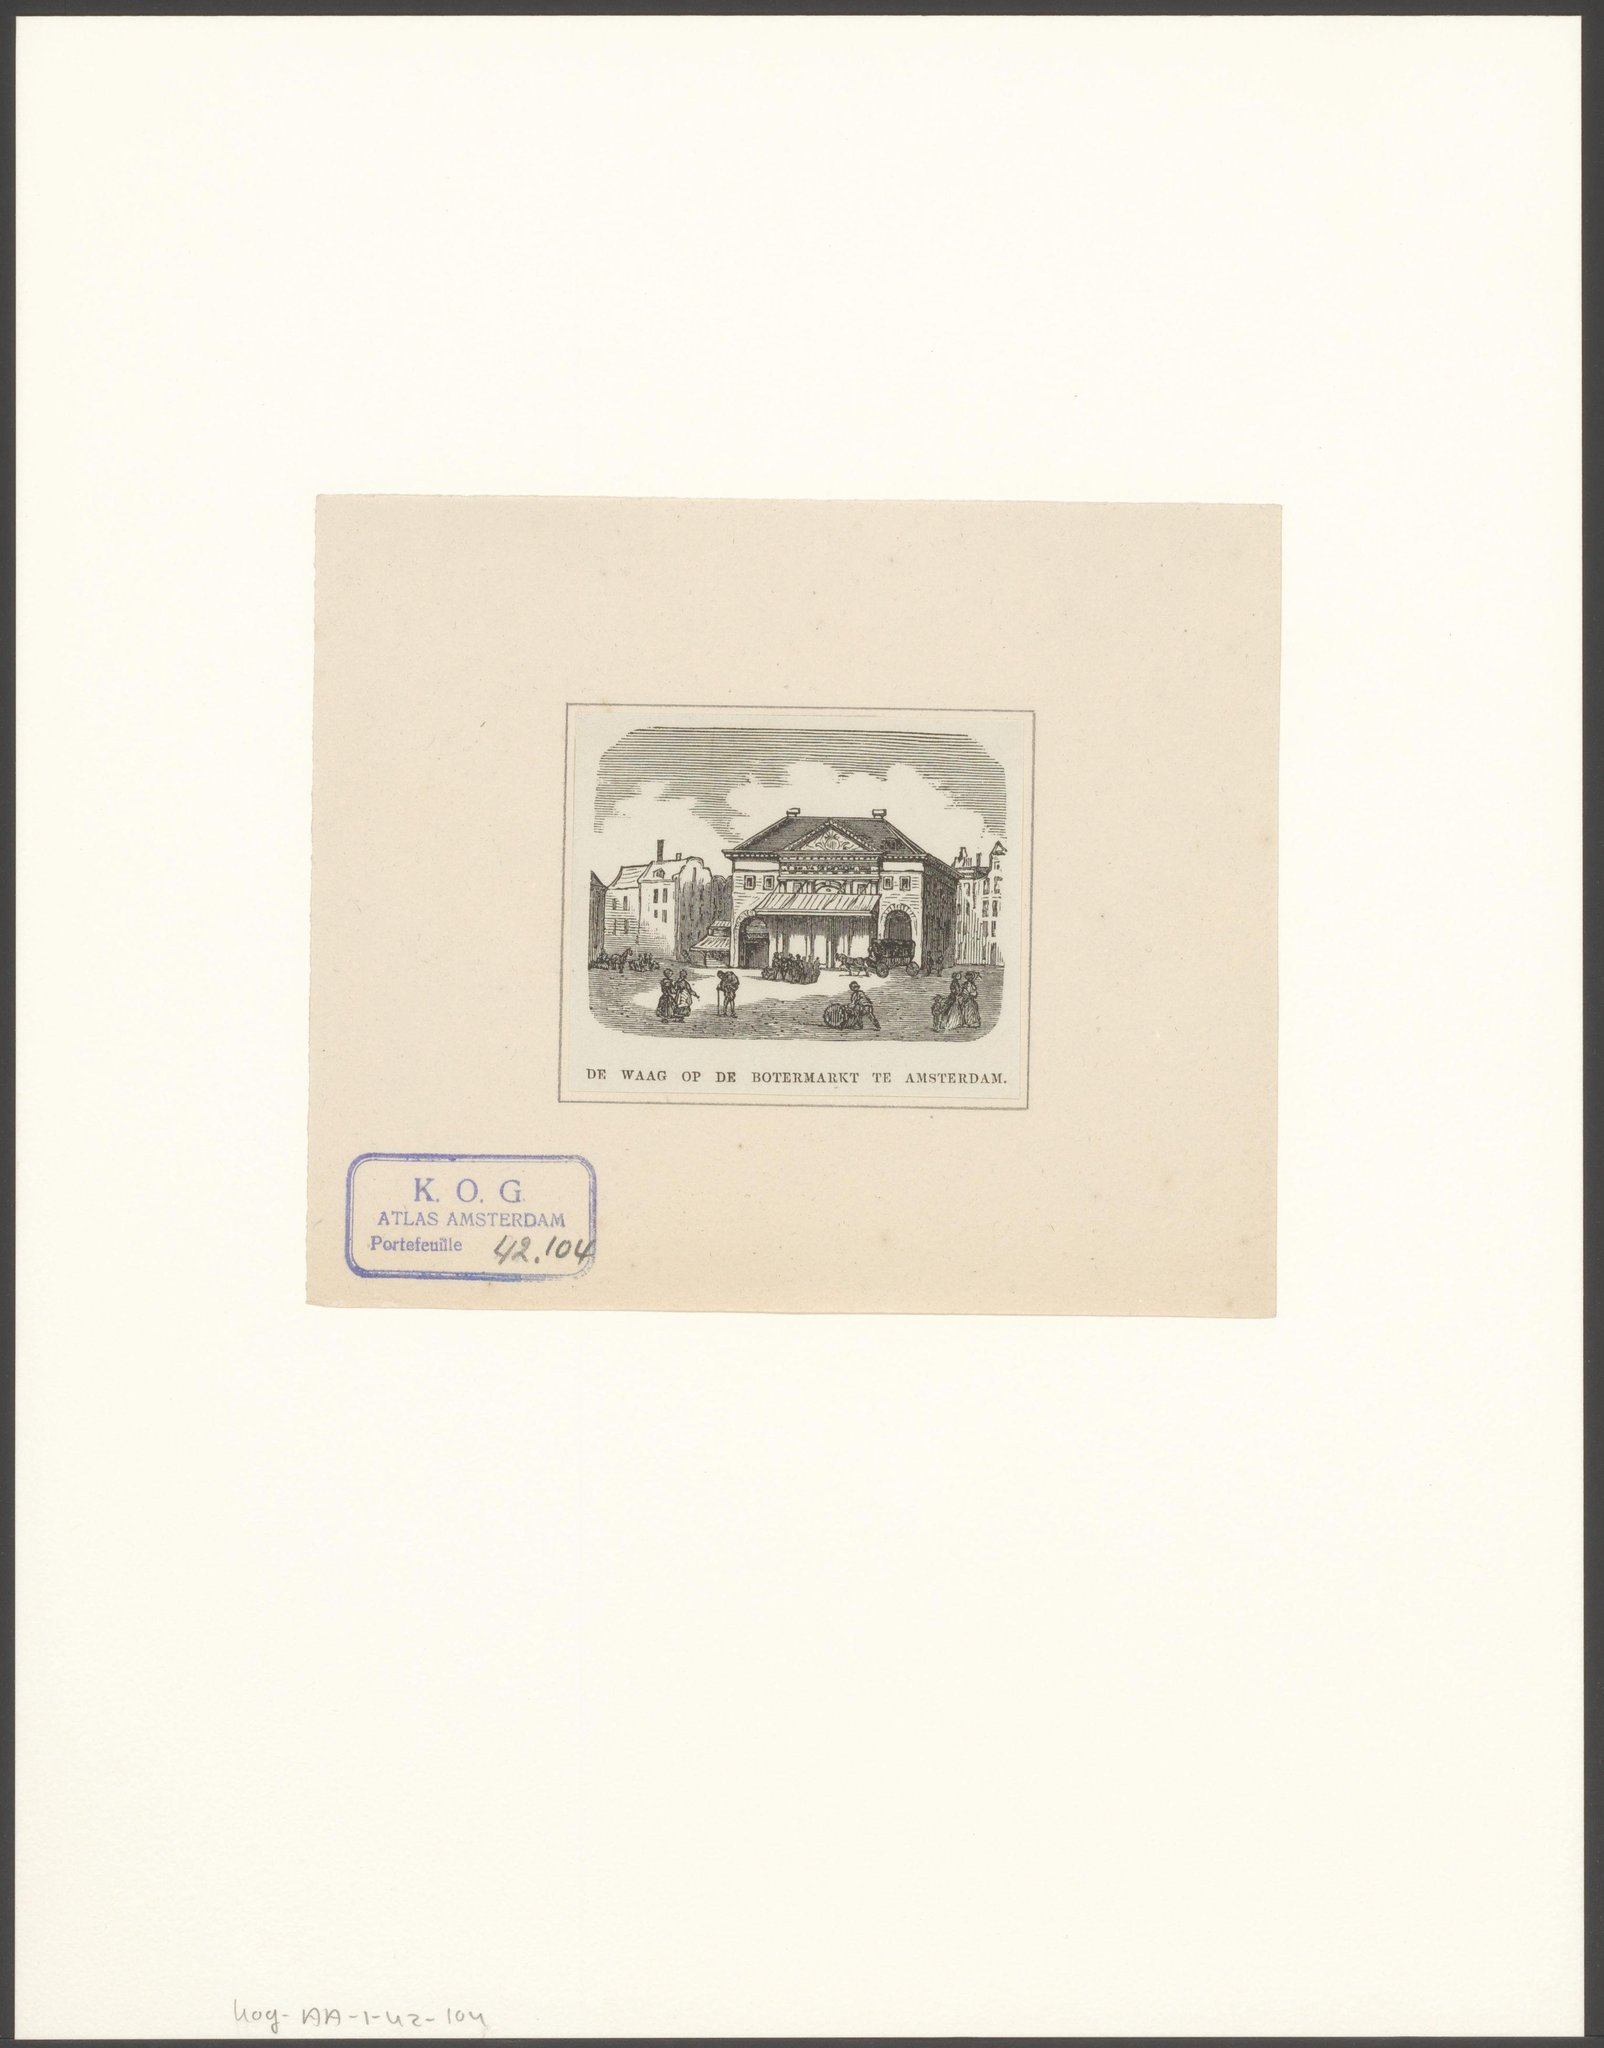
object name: print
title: De Waag op de Botermarkt te Amsterdam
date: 1861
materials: paper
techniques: letterpress printing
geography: leiden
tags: weigh-house, amsterdam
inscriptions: collector's mark: Lugt 1641b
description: Prent onderdeel van een grotere volksprent: Nederlandsche hoofdgebouwen, zie RP-P-OB-206.587.